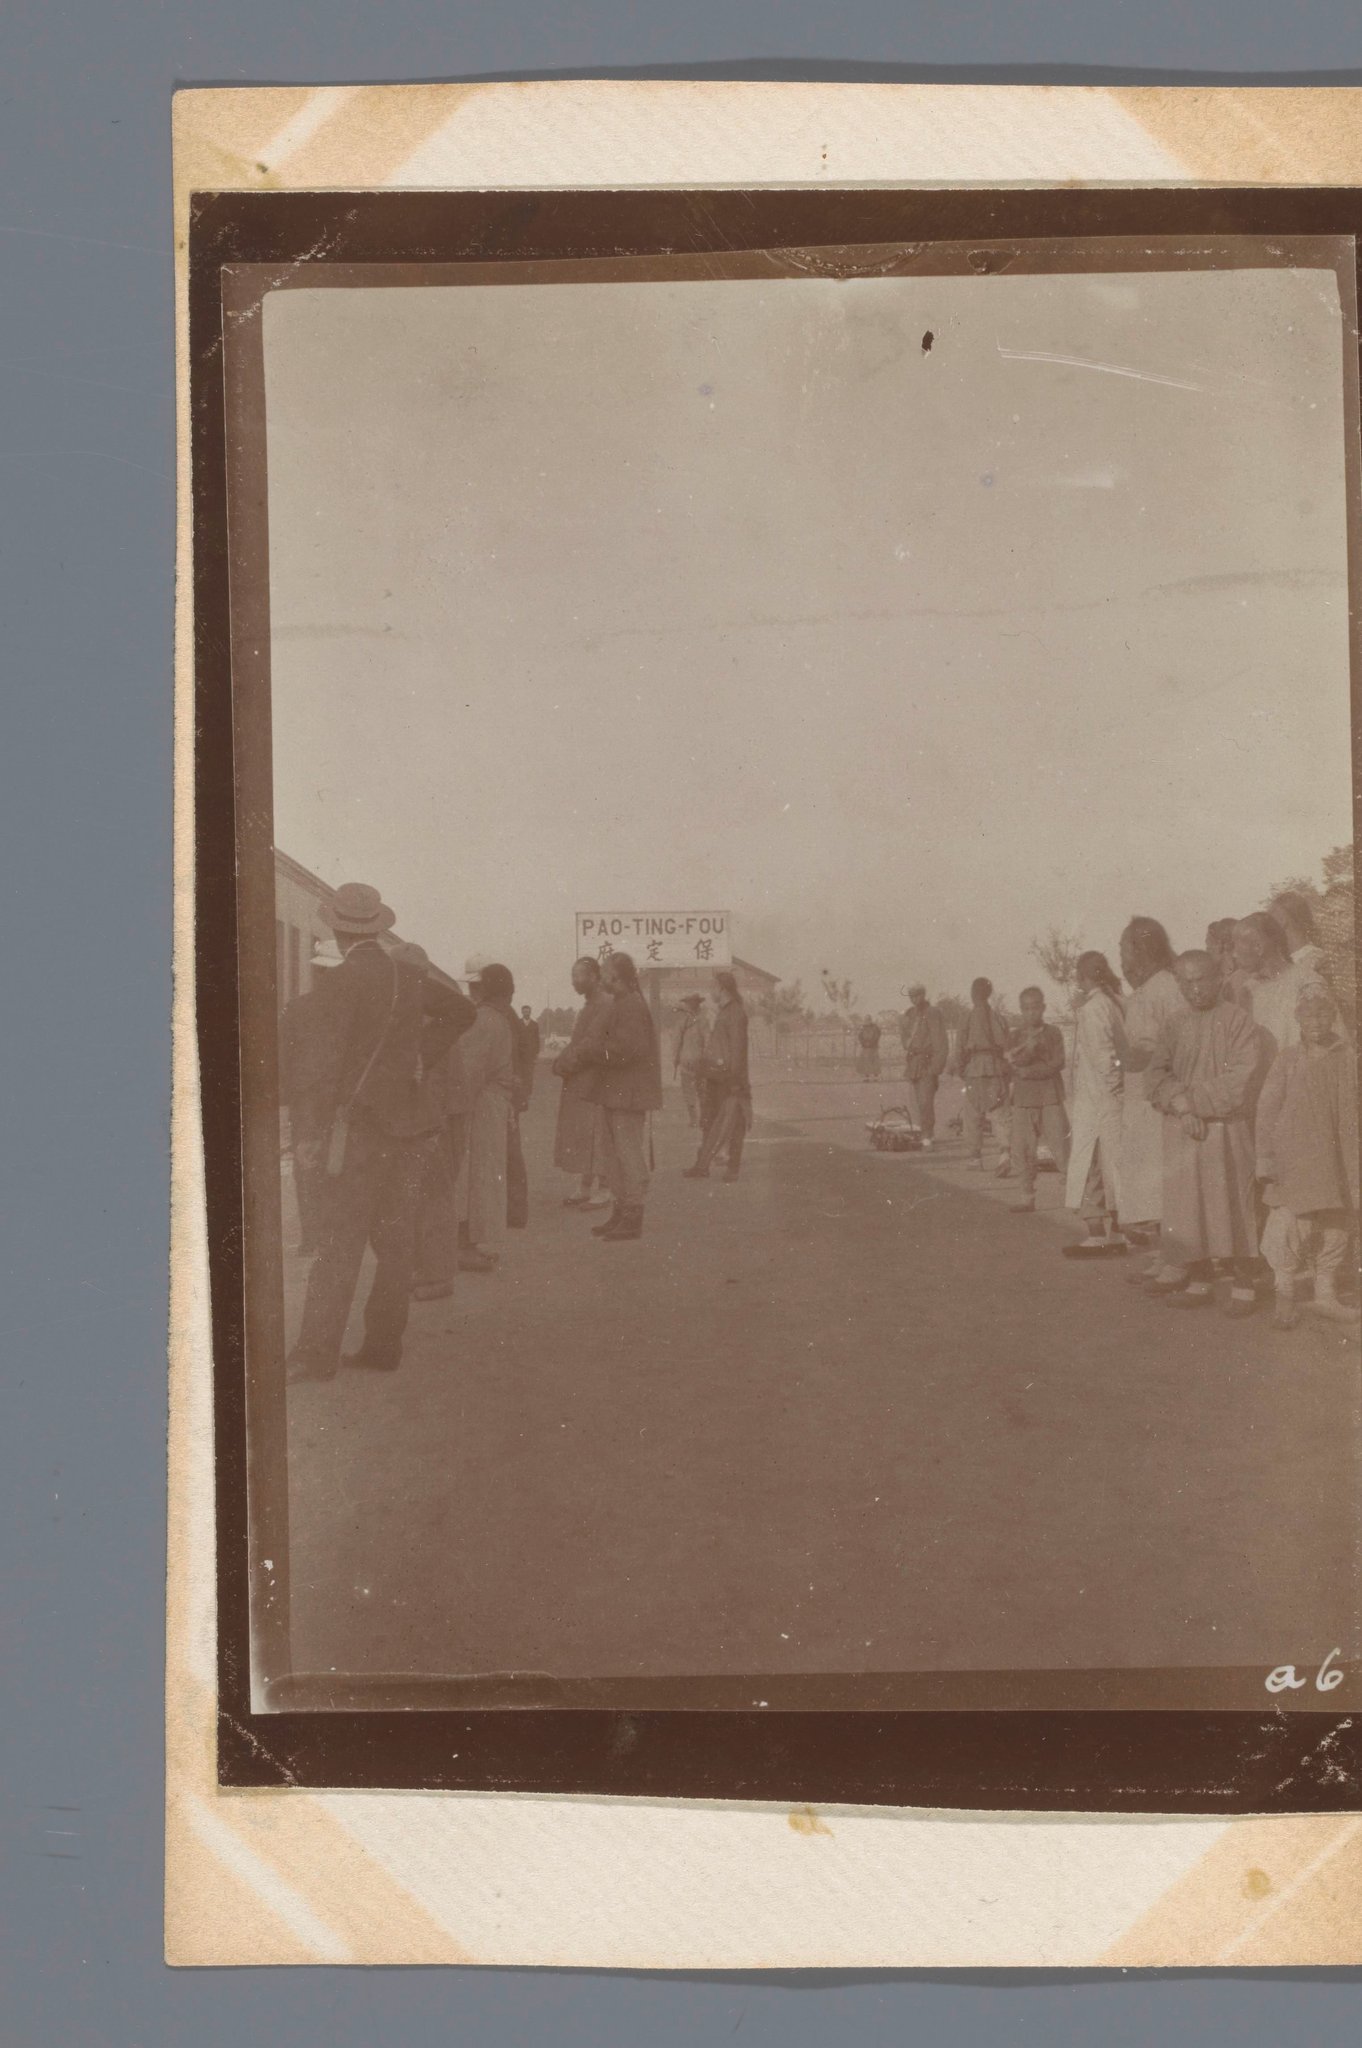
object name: photograph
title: Wachtende mensen op een station van de plaats Pao-Ting-Fou, China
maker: jan adriani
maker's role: fotograaf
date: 1907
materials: paper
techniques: collodion silver print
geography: baoding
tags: station; shelter (railway, tramway), 'en route', traveller under way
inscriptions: inscription: ‘Mevrouw Adriani/ Utrecht’